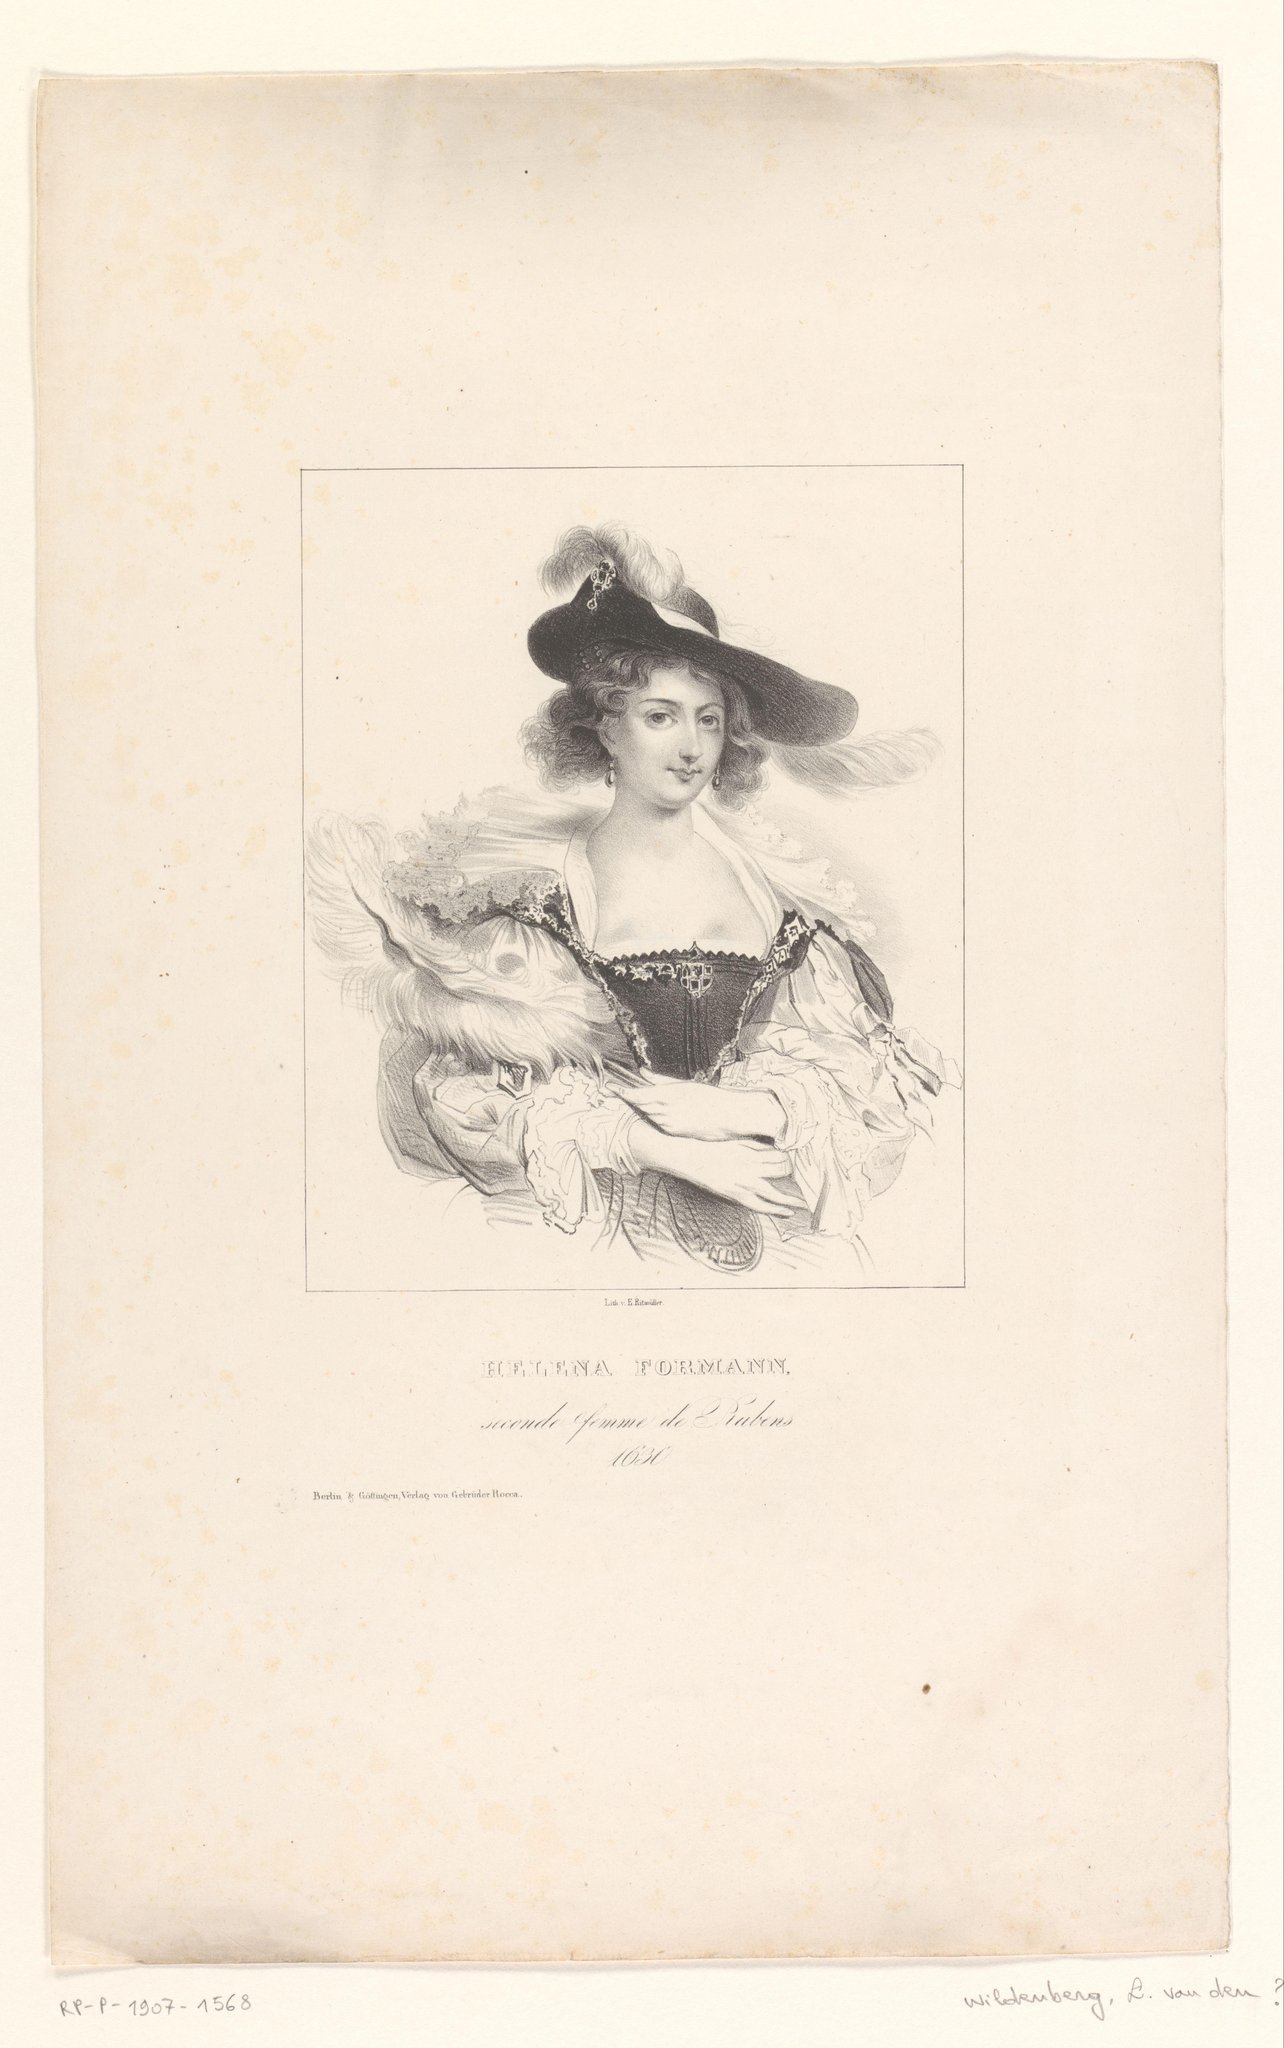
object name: print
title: Helena Formann, seconde femme de Rubens 1630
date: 1815-1868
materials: paper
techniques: lithograph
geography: gottingen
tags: antwerp, adult woman, head-gear, historical persons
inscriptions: collector's mark: Lugt 2228